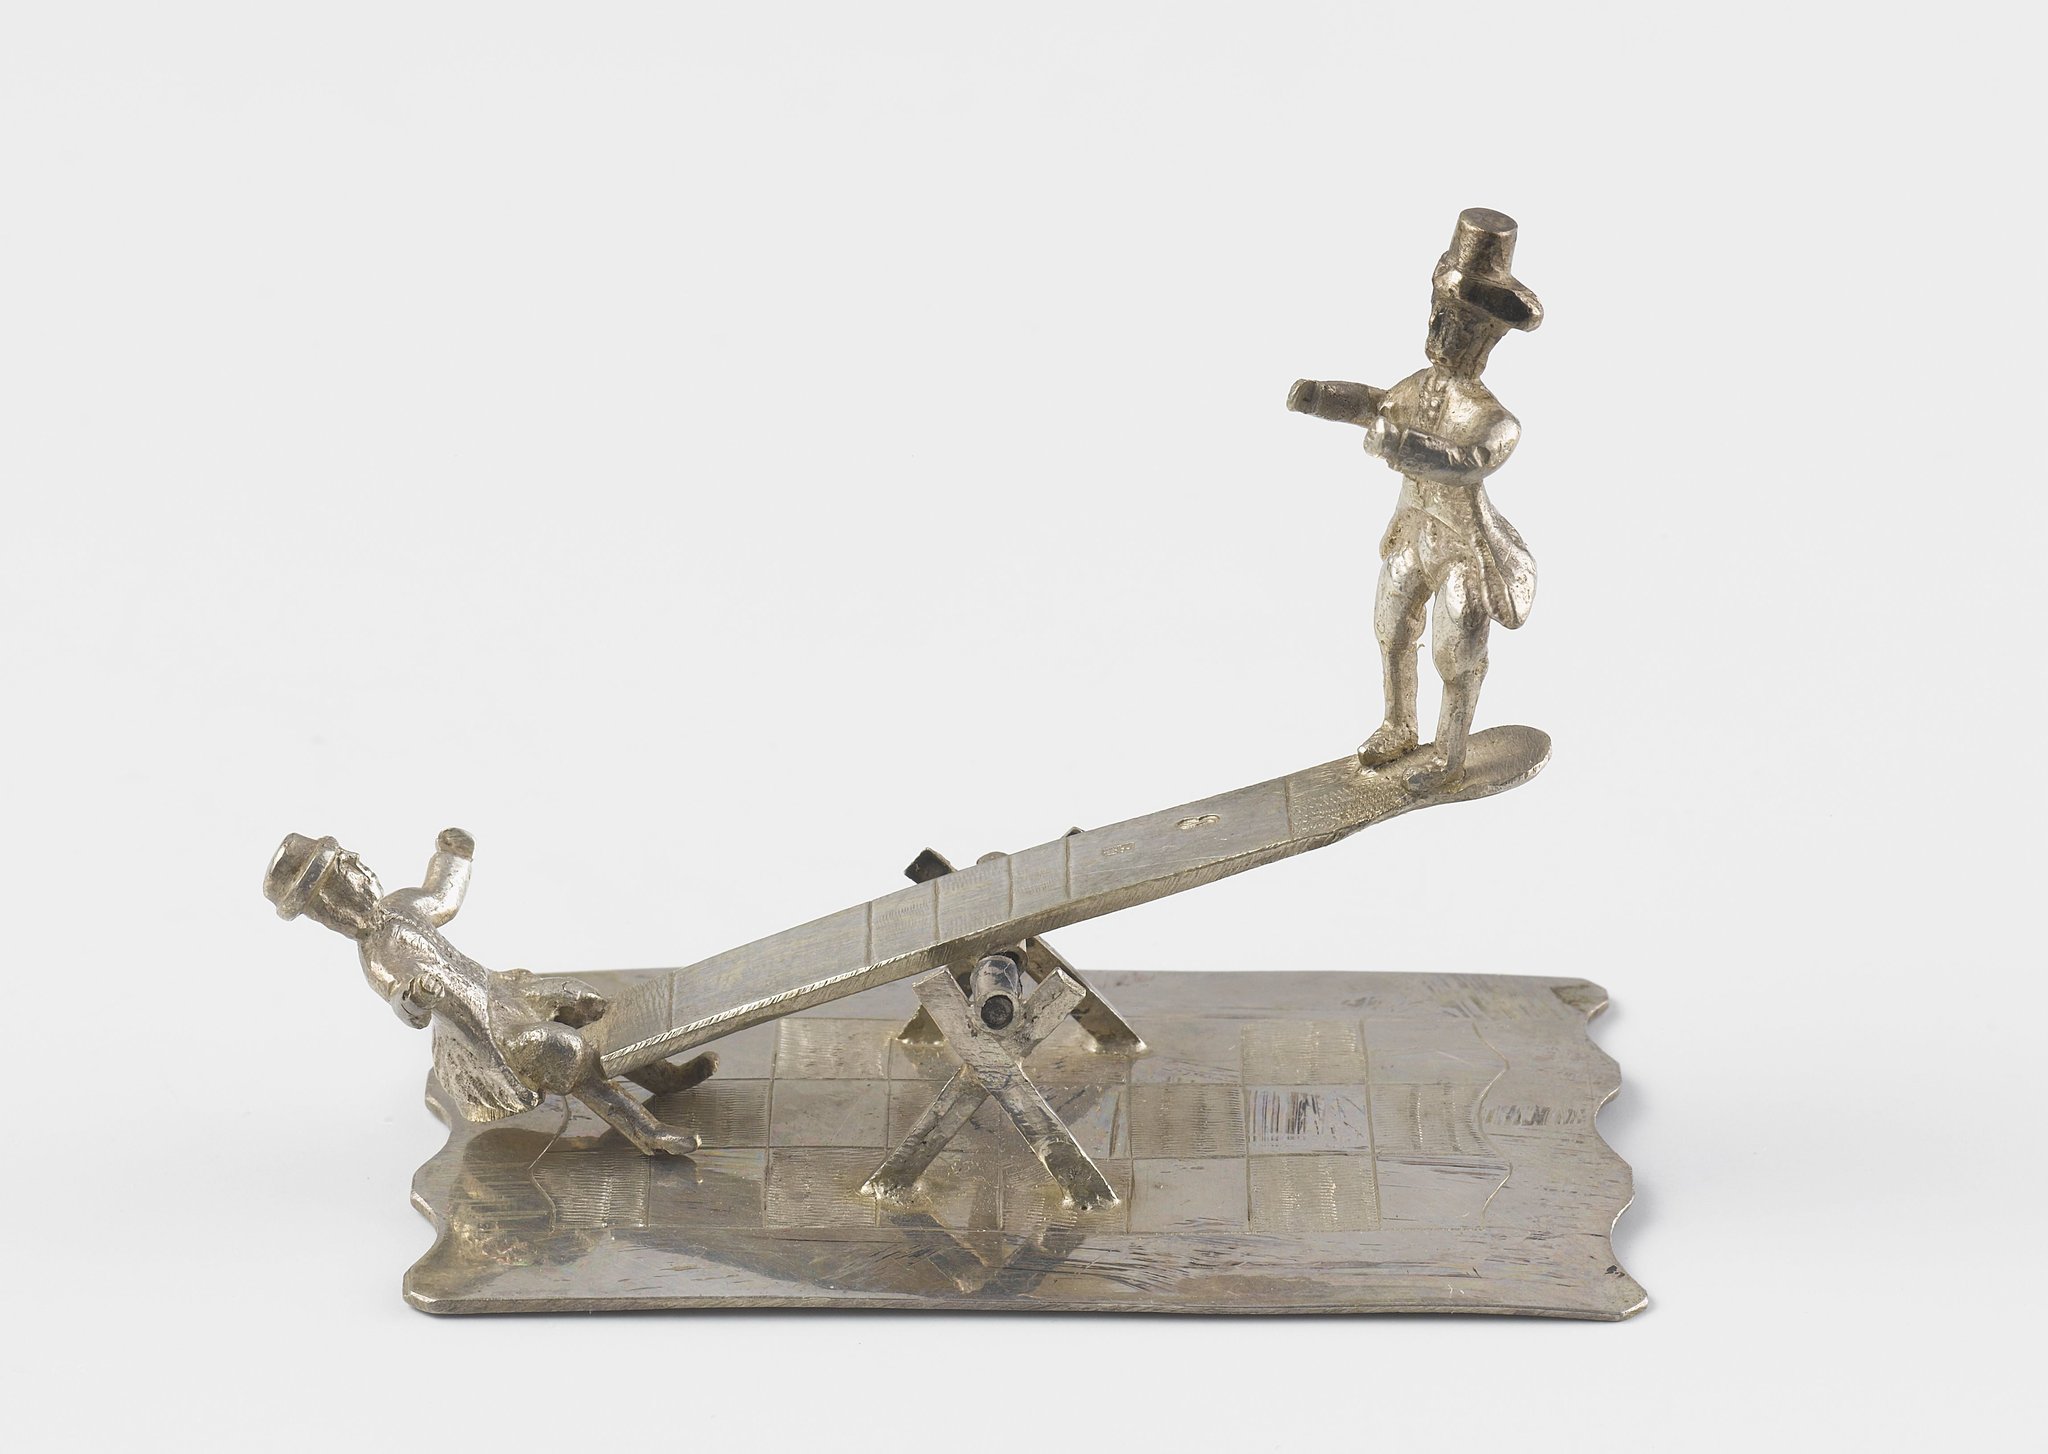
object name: miniature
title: Kinderen op wip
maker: anthonie hellegers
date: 1844-1867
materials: silver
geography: bruinisse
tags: seesaw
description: Op een langwerpige plaat staat een wip. Op de wip zit aan de ene kant een man en aan de andere kant staat een man. De korte zijde van de plaat is geschulpt. In de plaat is een ruitpatroon gegraveerd. Het beeld is gemerkt: mt.= A. Hellegers en een geschreven S.